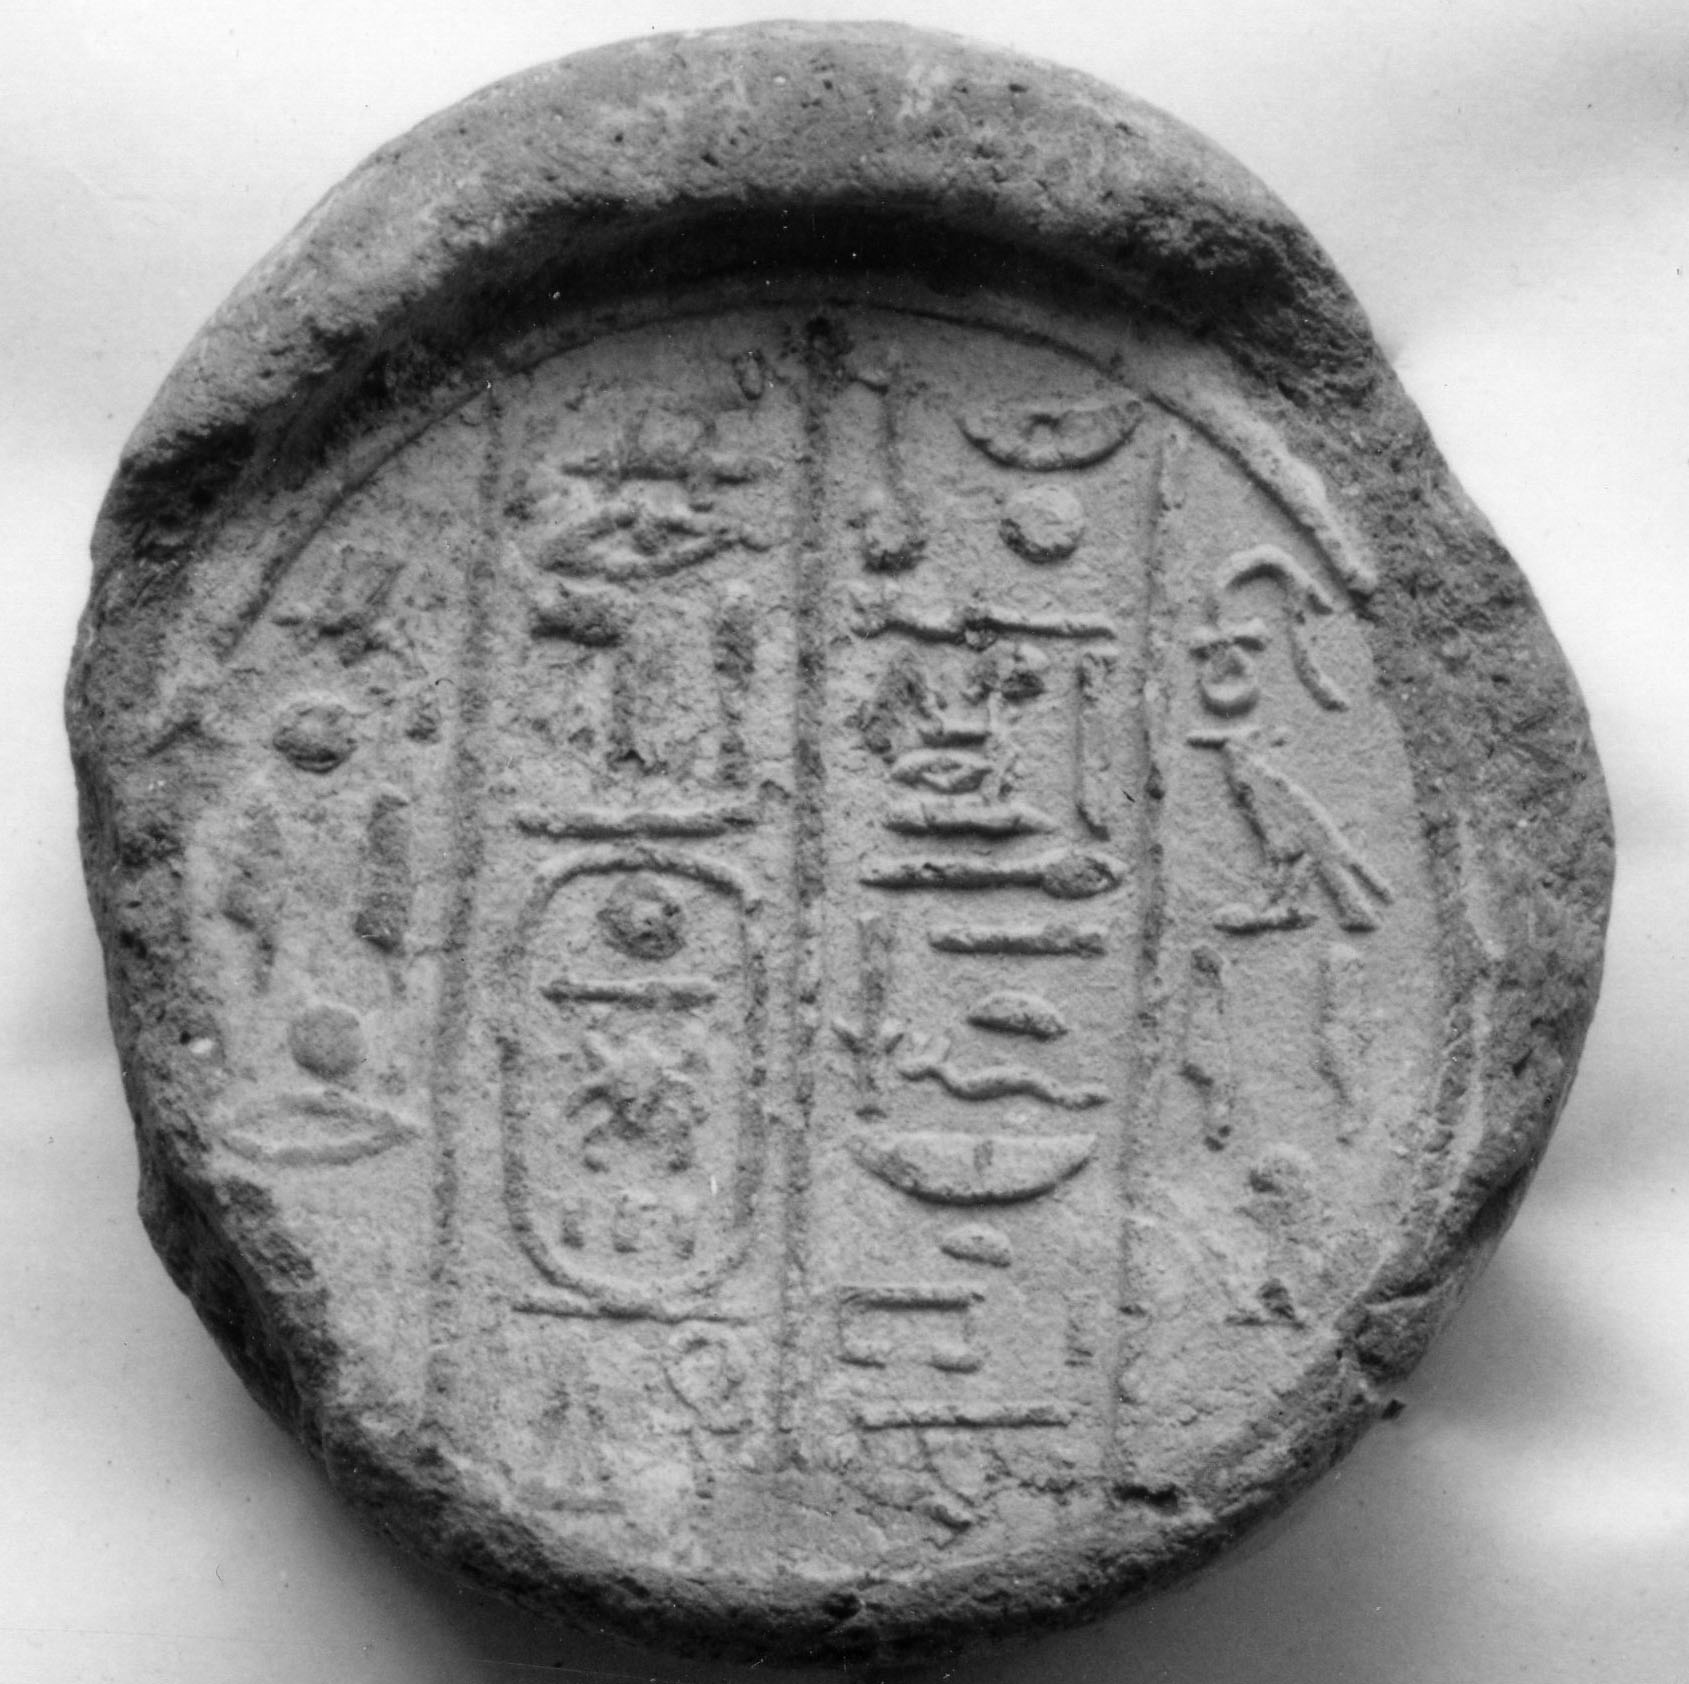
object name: cone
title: Funerary Cones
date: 1550-1295 BCE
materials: pottery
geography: egypt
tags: hieroglyphs